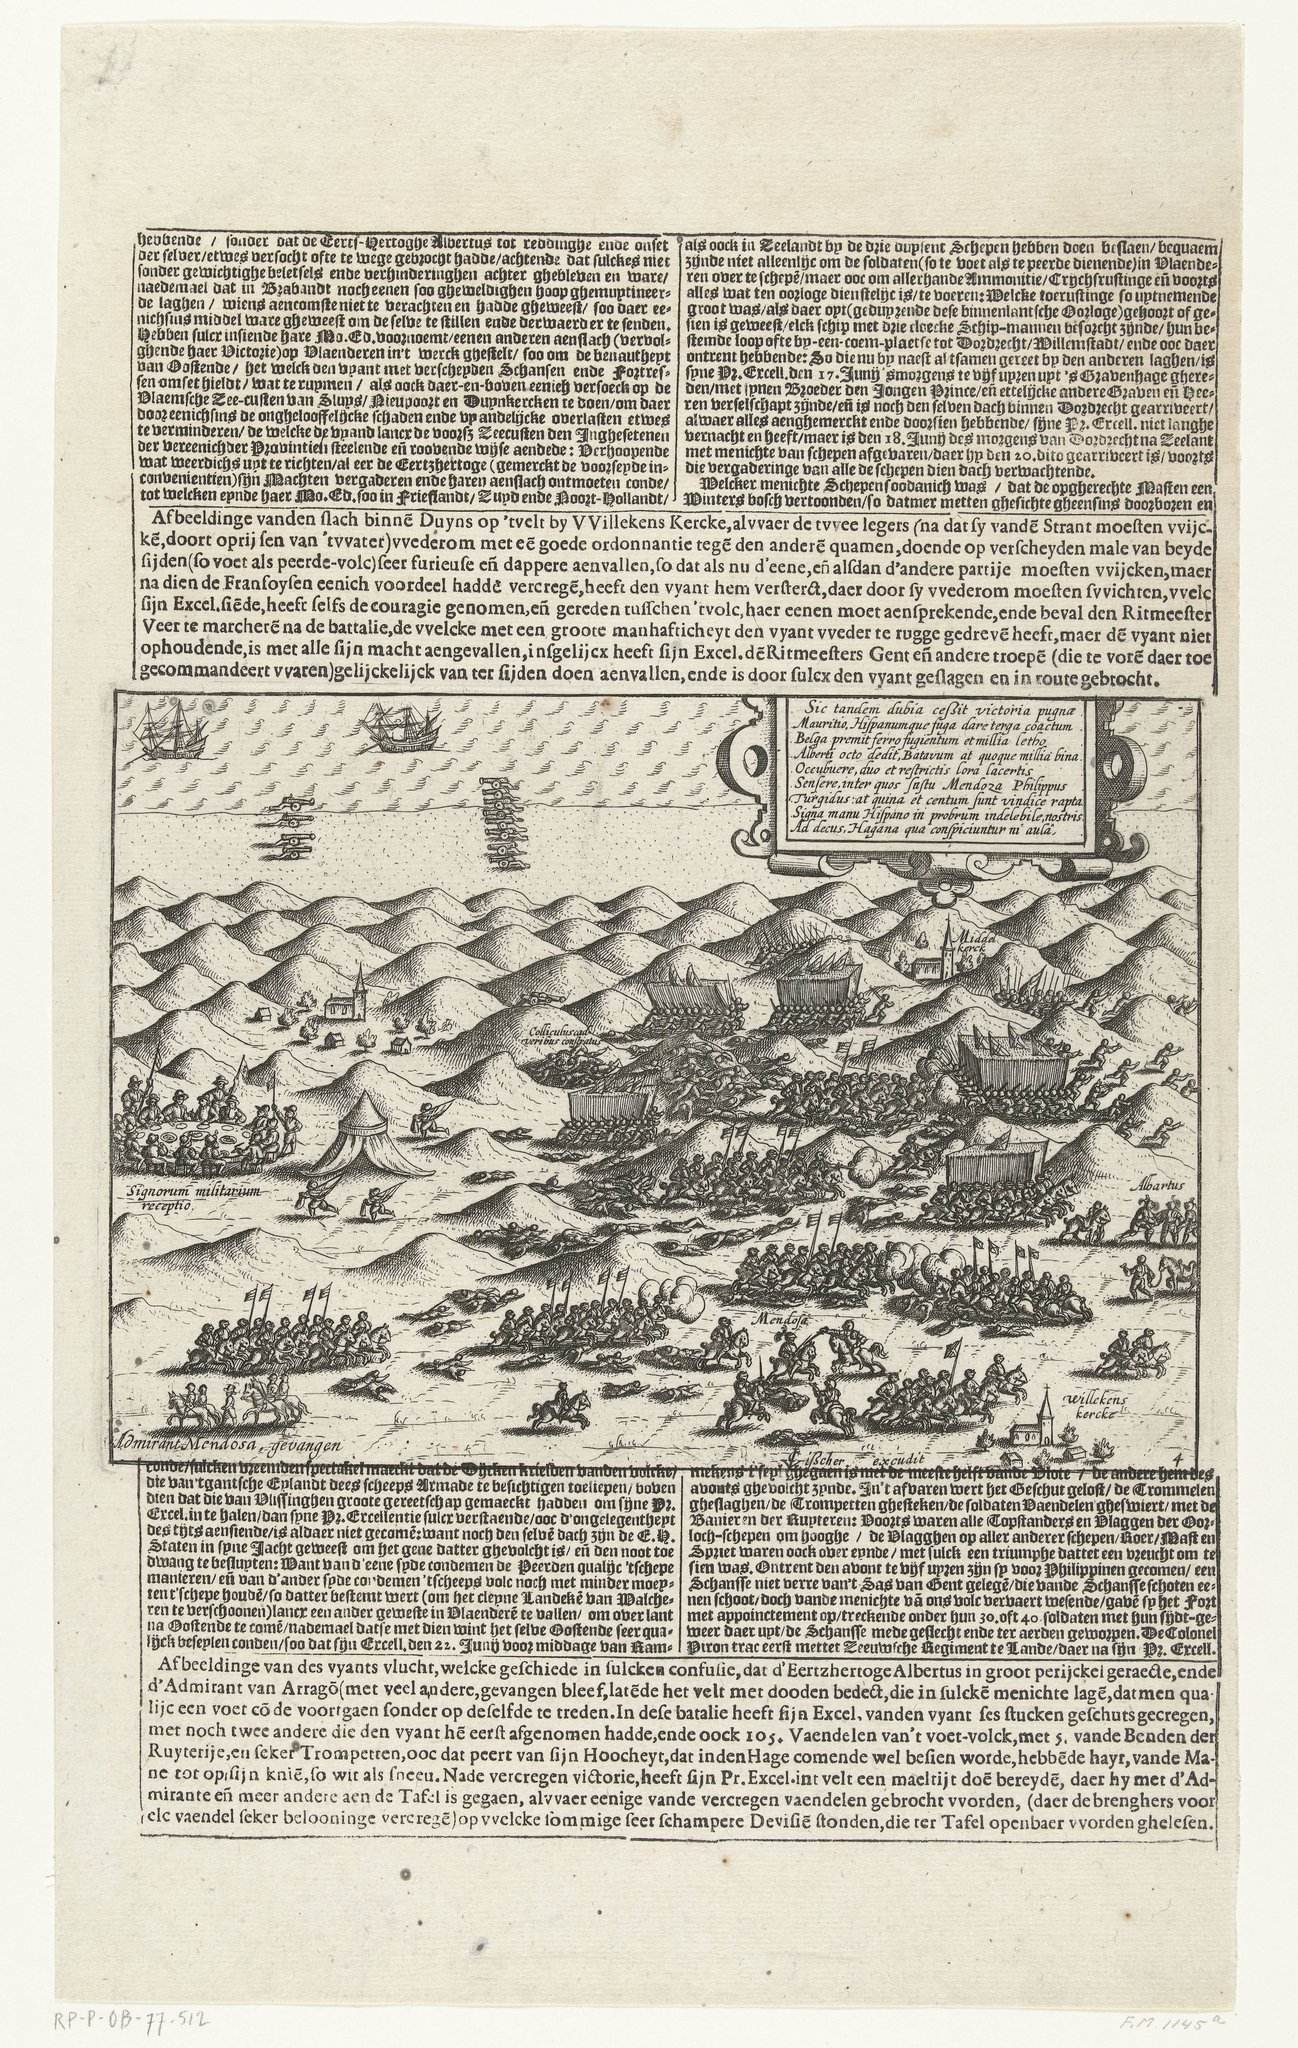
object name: print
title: Nieuwsbericht over de slag bij Nieuwpoort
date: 1600-1649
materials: paper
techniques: etching, letterpress printing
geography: northern netherlands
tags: the hague, maurice (prince of orange), albrecht aartshertog van oostenrijk, battle (+ land forces), battle of nieuwpoort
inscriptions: address: ‘CJVisscher excudit’, number: ‘4’